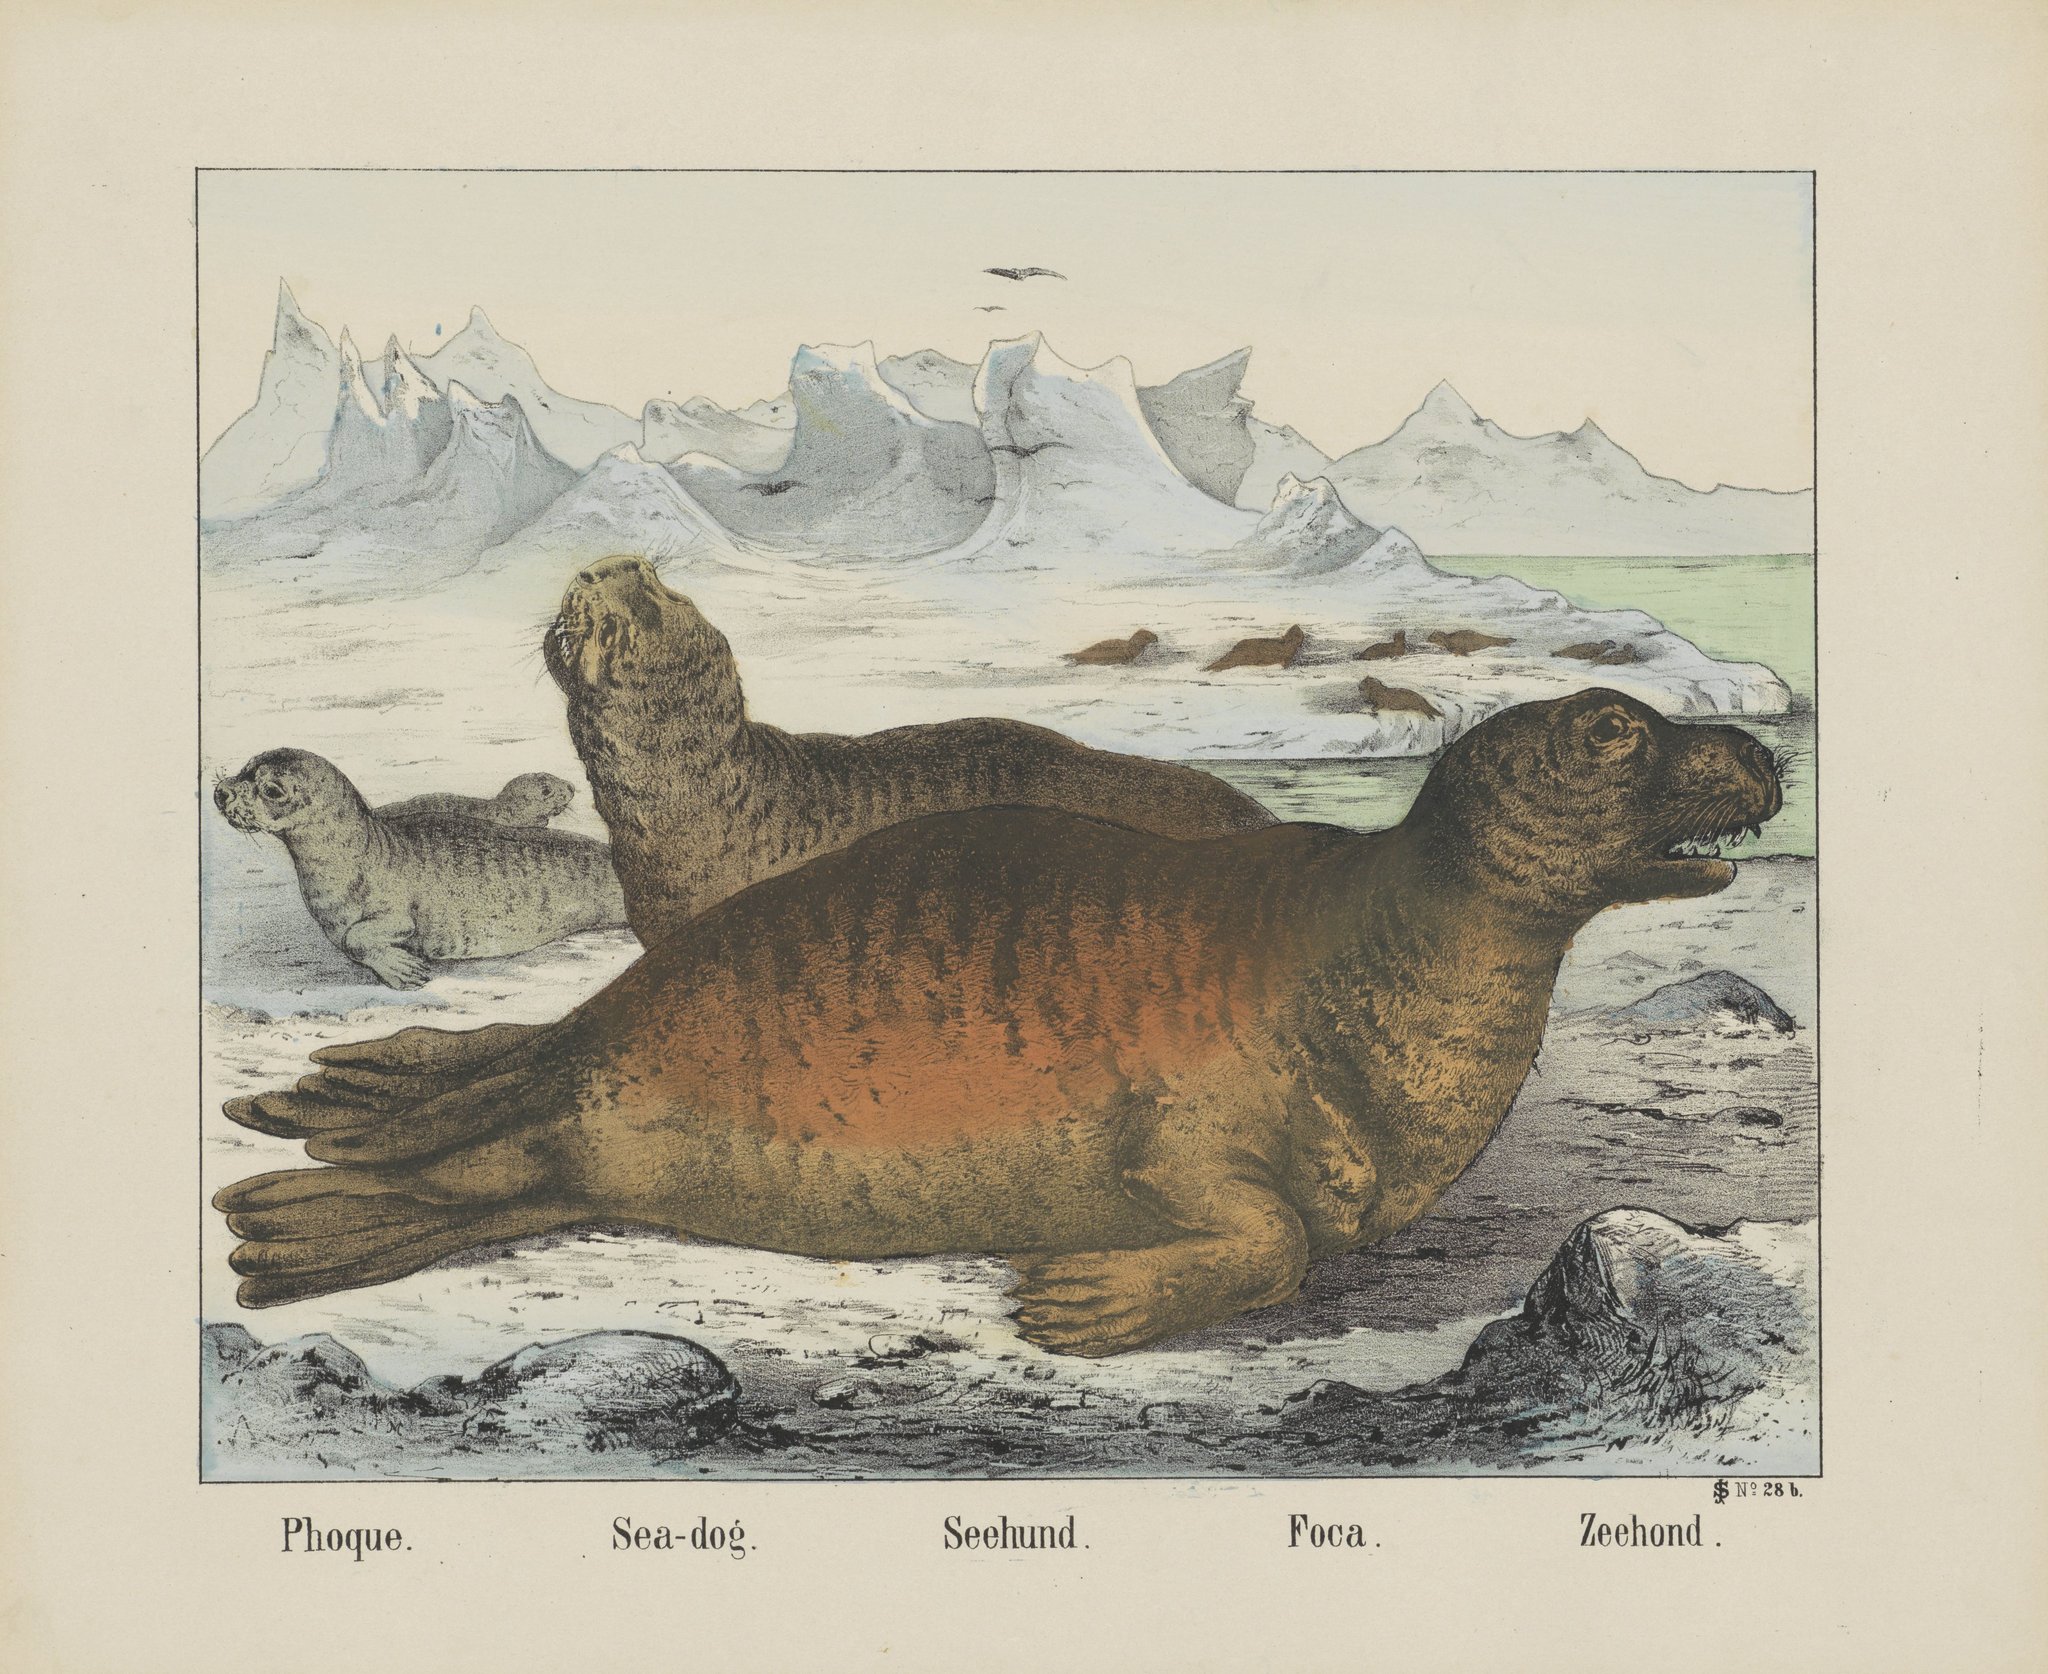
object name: print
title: Phoque. / Sea-dog. / Seehund. / Foca. / Zeehond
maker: Anonymous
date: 1829-1880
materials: paper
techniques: colour, letterpress printing, lithograph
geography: europe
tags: swimming mammals: seal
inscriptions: collector's mark: Lugt 2760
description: Zeehonden in een poollandschap. Genummerd rechtsonder: No. 28b.